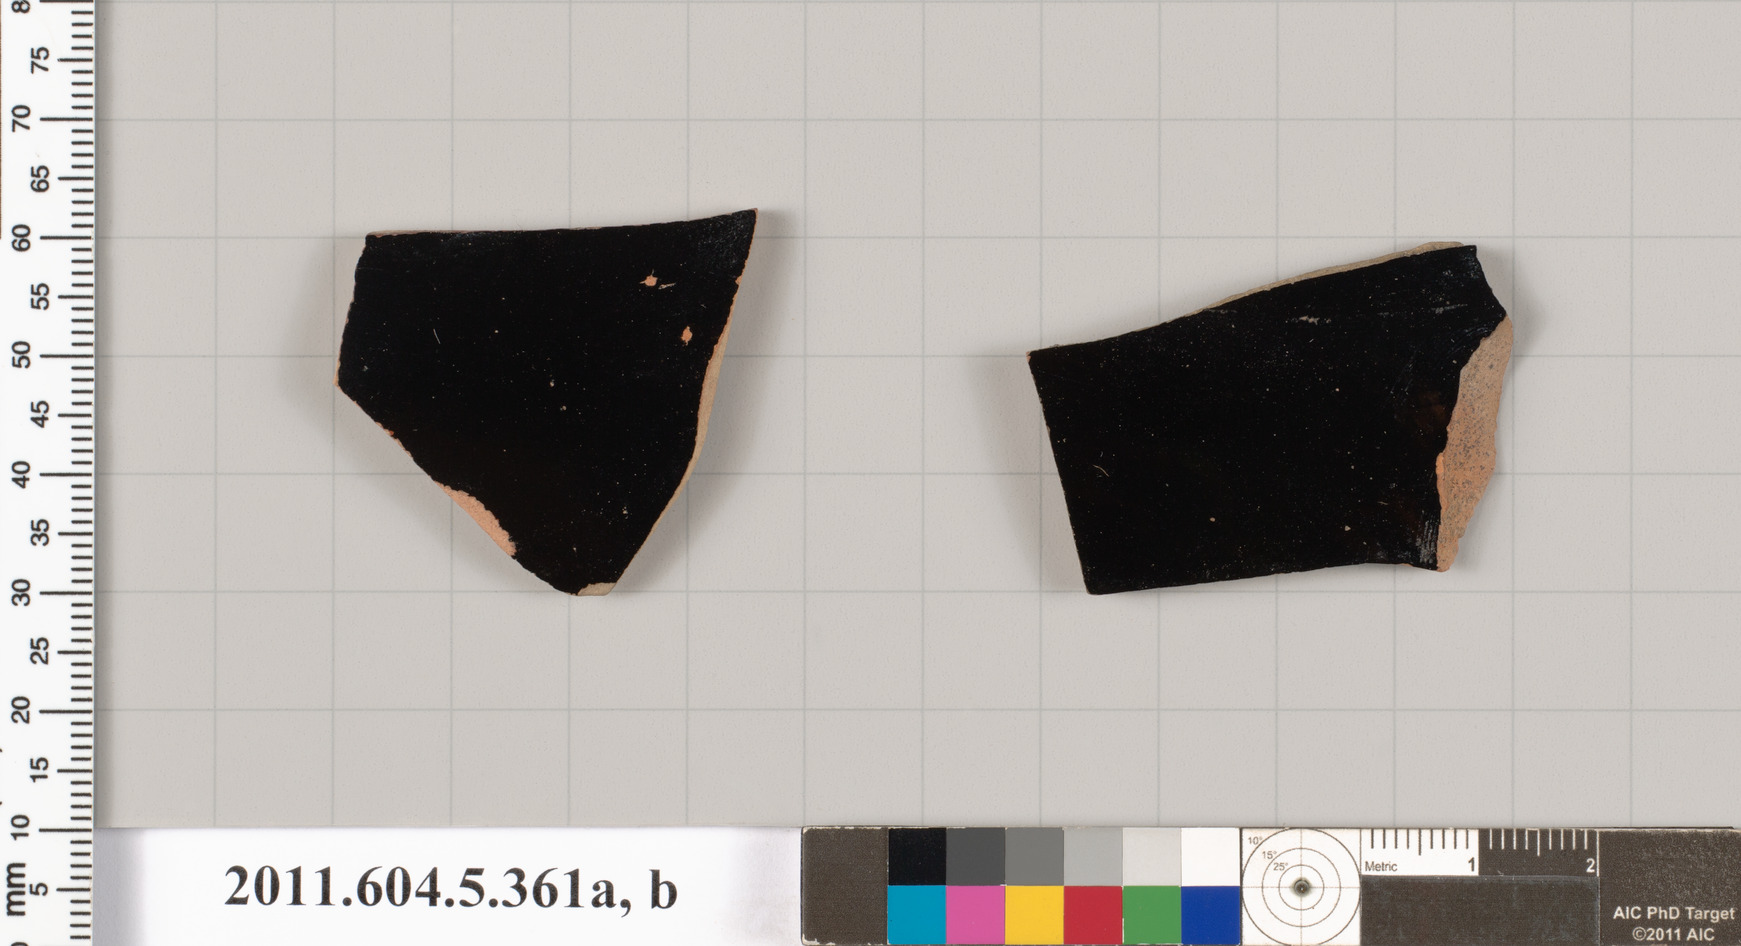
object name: kylix fragment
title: Terracotta fragments of kylikes (drinking cups)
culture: greek, attic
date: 600-401 BCE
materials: terracotta